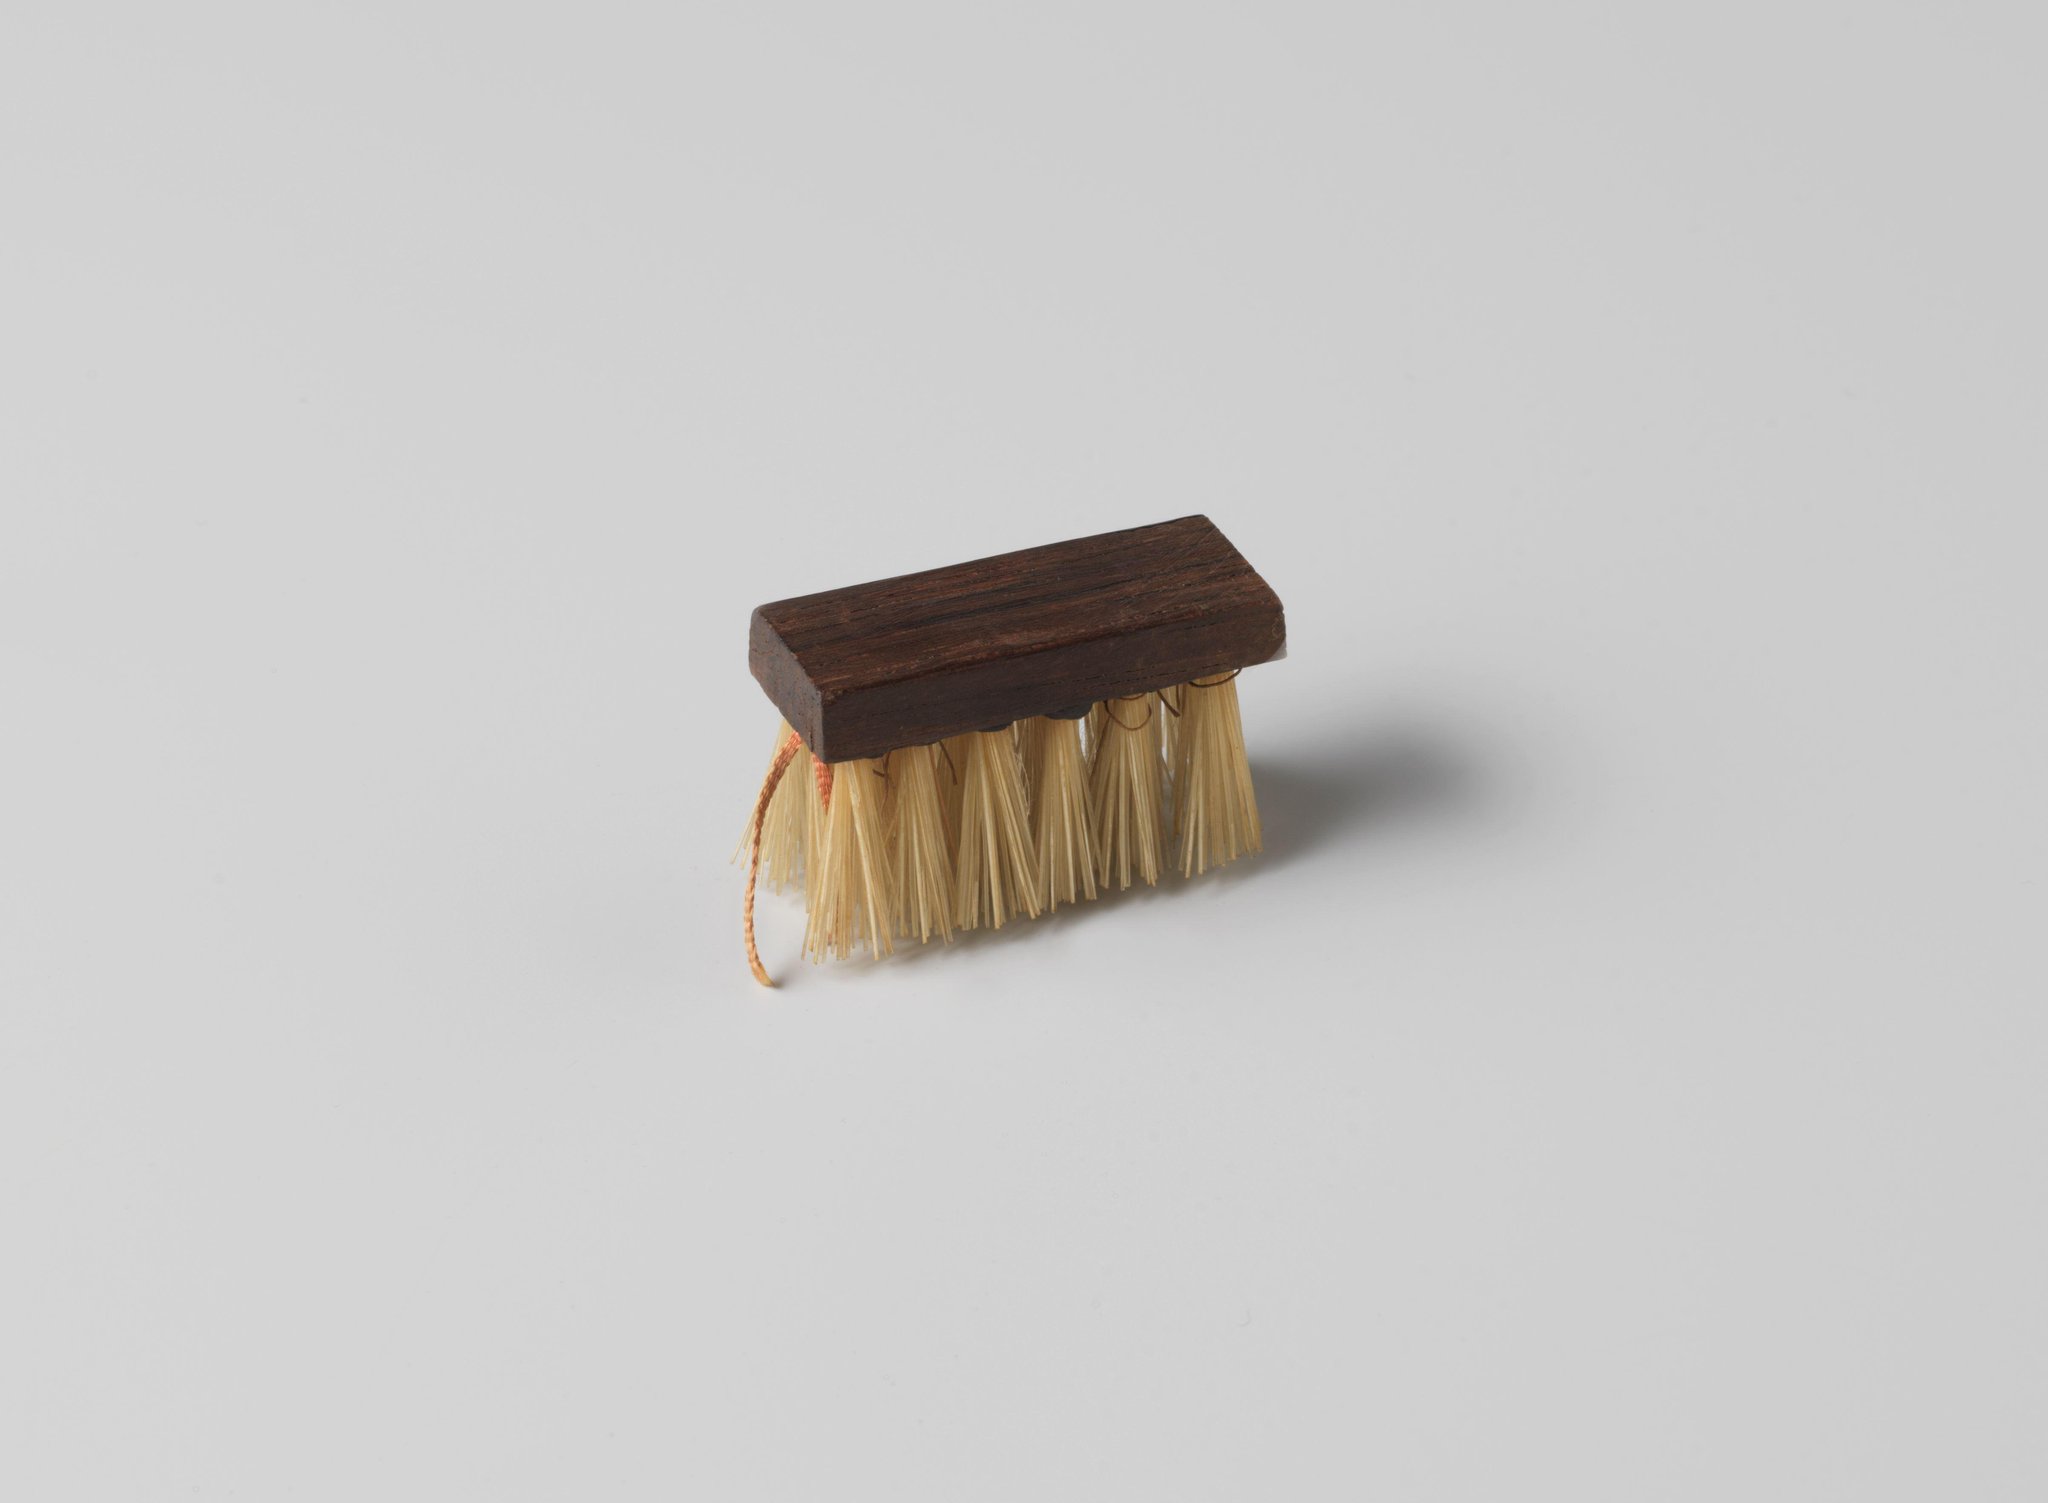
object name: miniature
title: Boender met rechthoekige rug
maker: Anonymous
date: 1675-1699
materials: wood, silk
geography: amsterdam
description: Een rechthoekige boender of borstel van palissanderhout ingezet met varkenshaar; roze zijden band gelijk met wat varkenshaar ingezet.